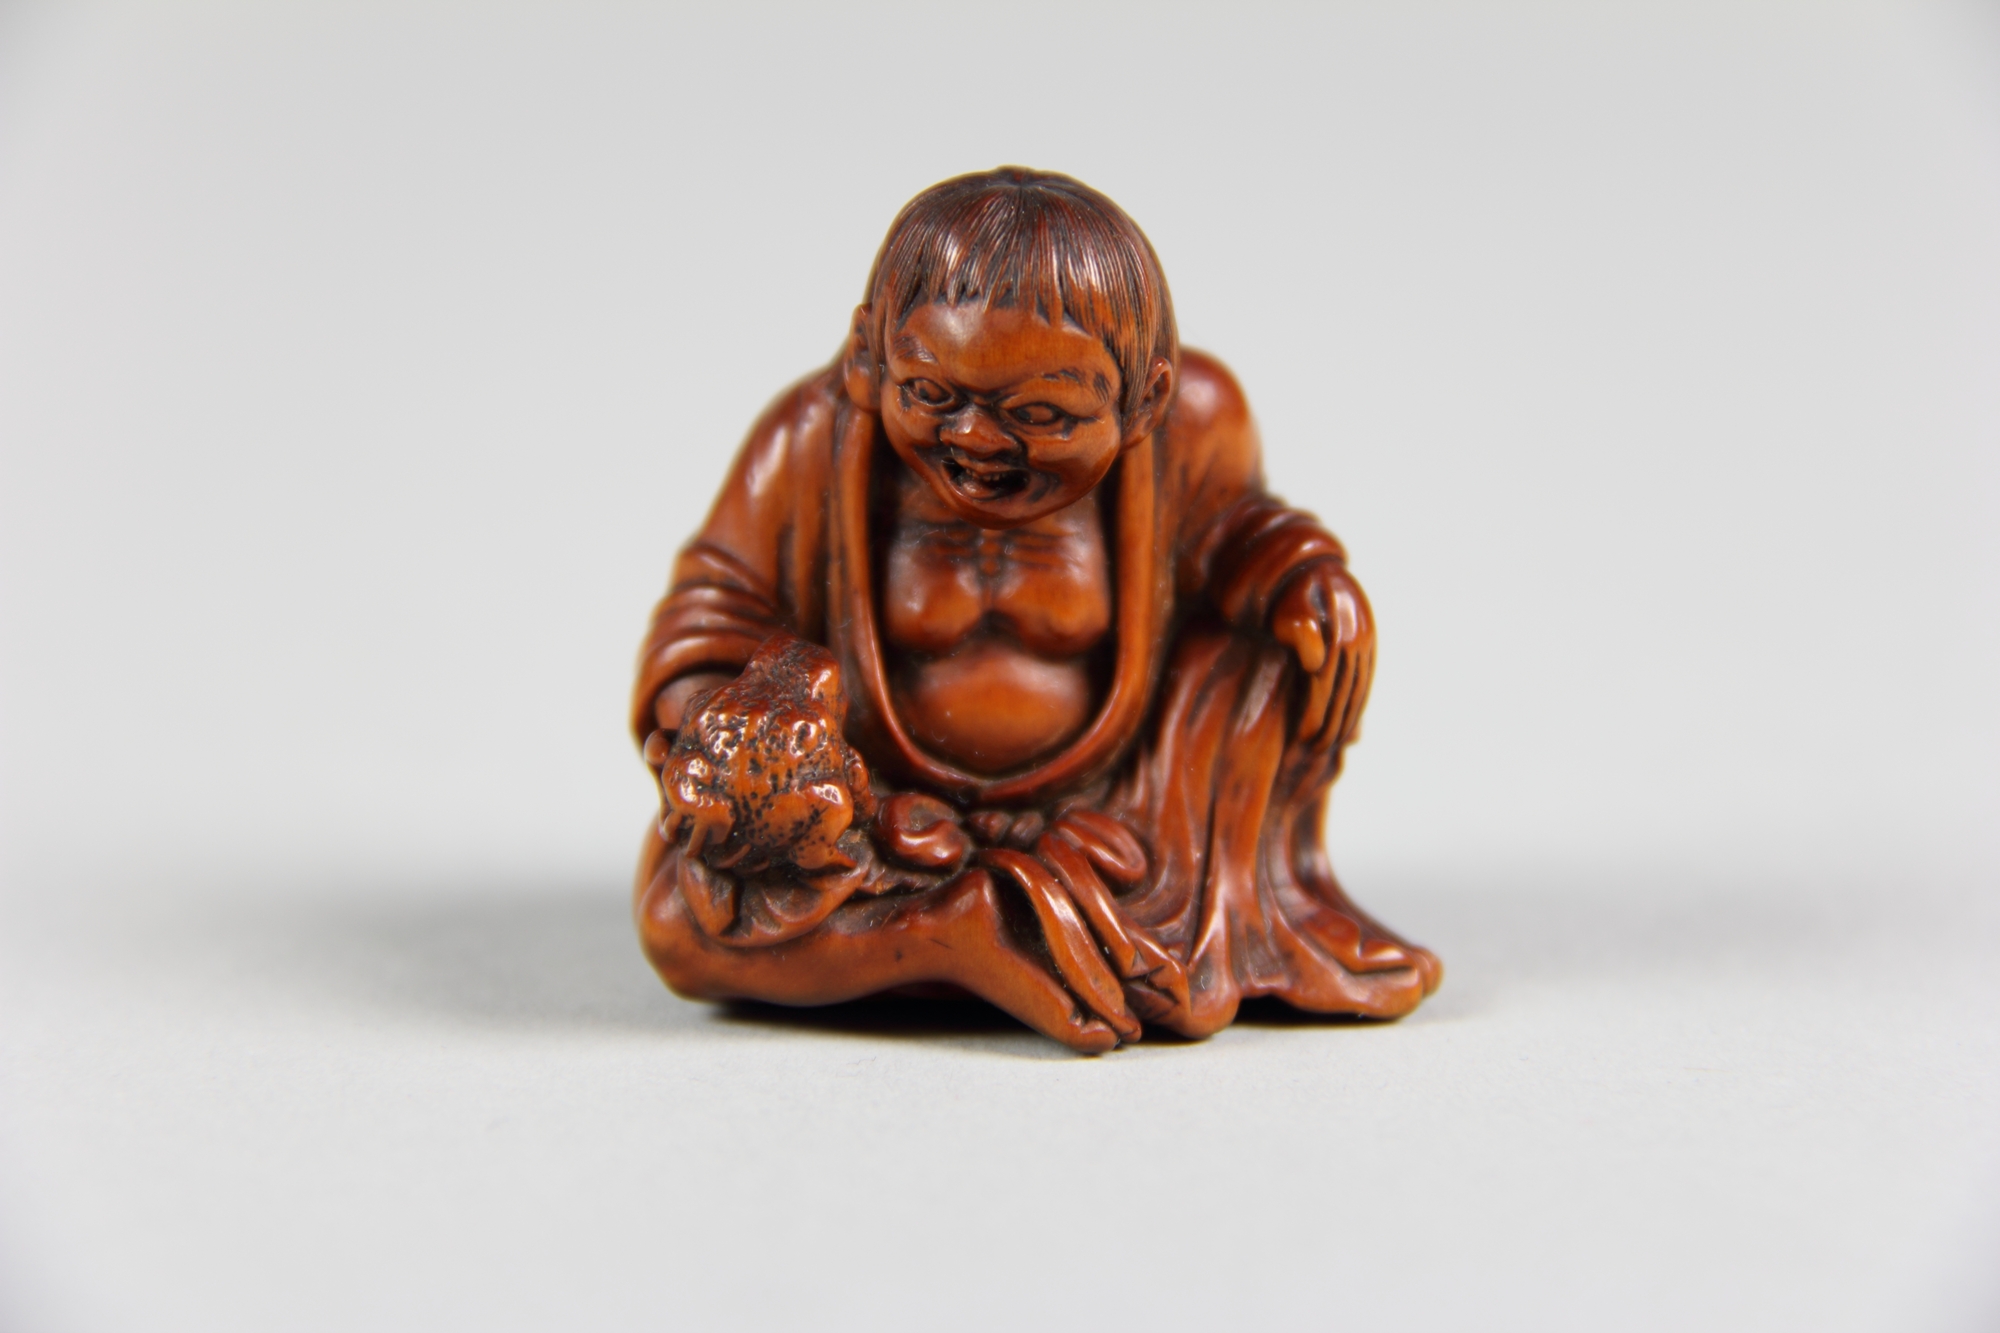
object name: netsuke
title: Netsuke of Old Woman with a Toad in her Hand (Gama Sennin)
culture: japanese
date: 1801-1900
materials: wood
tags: women,frogs